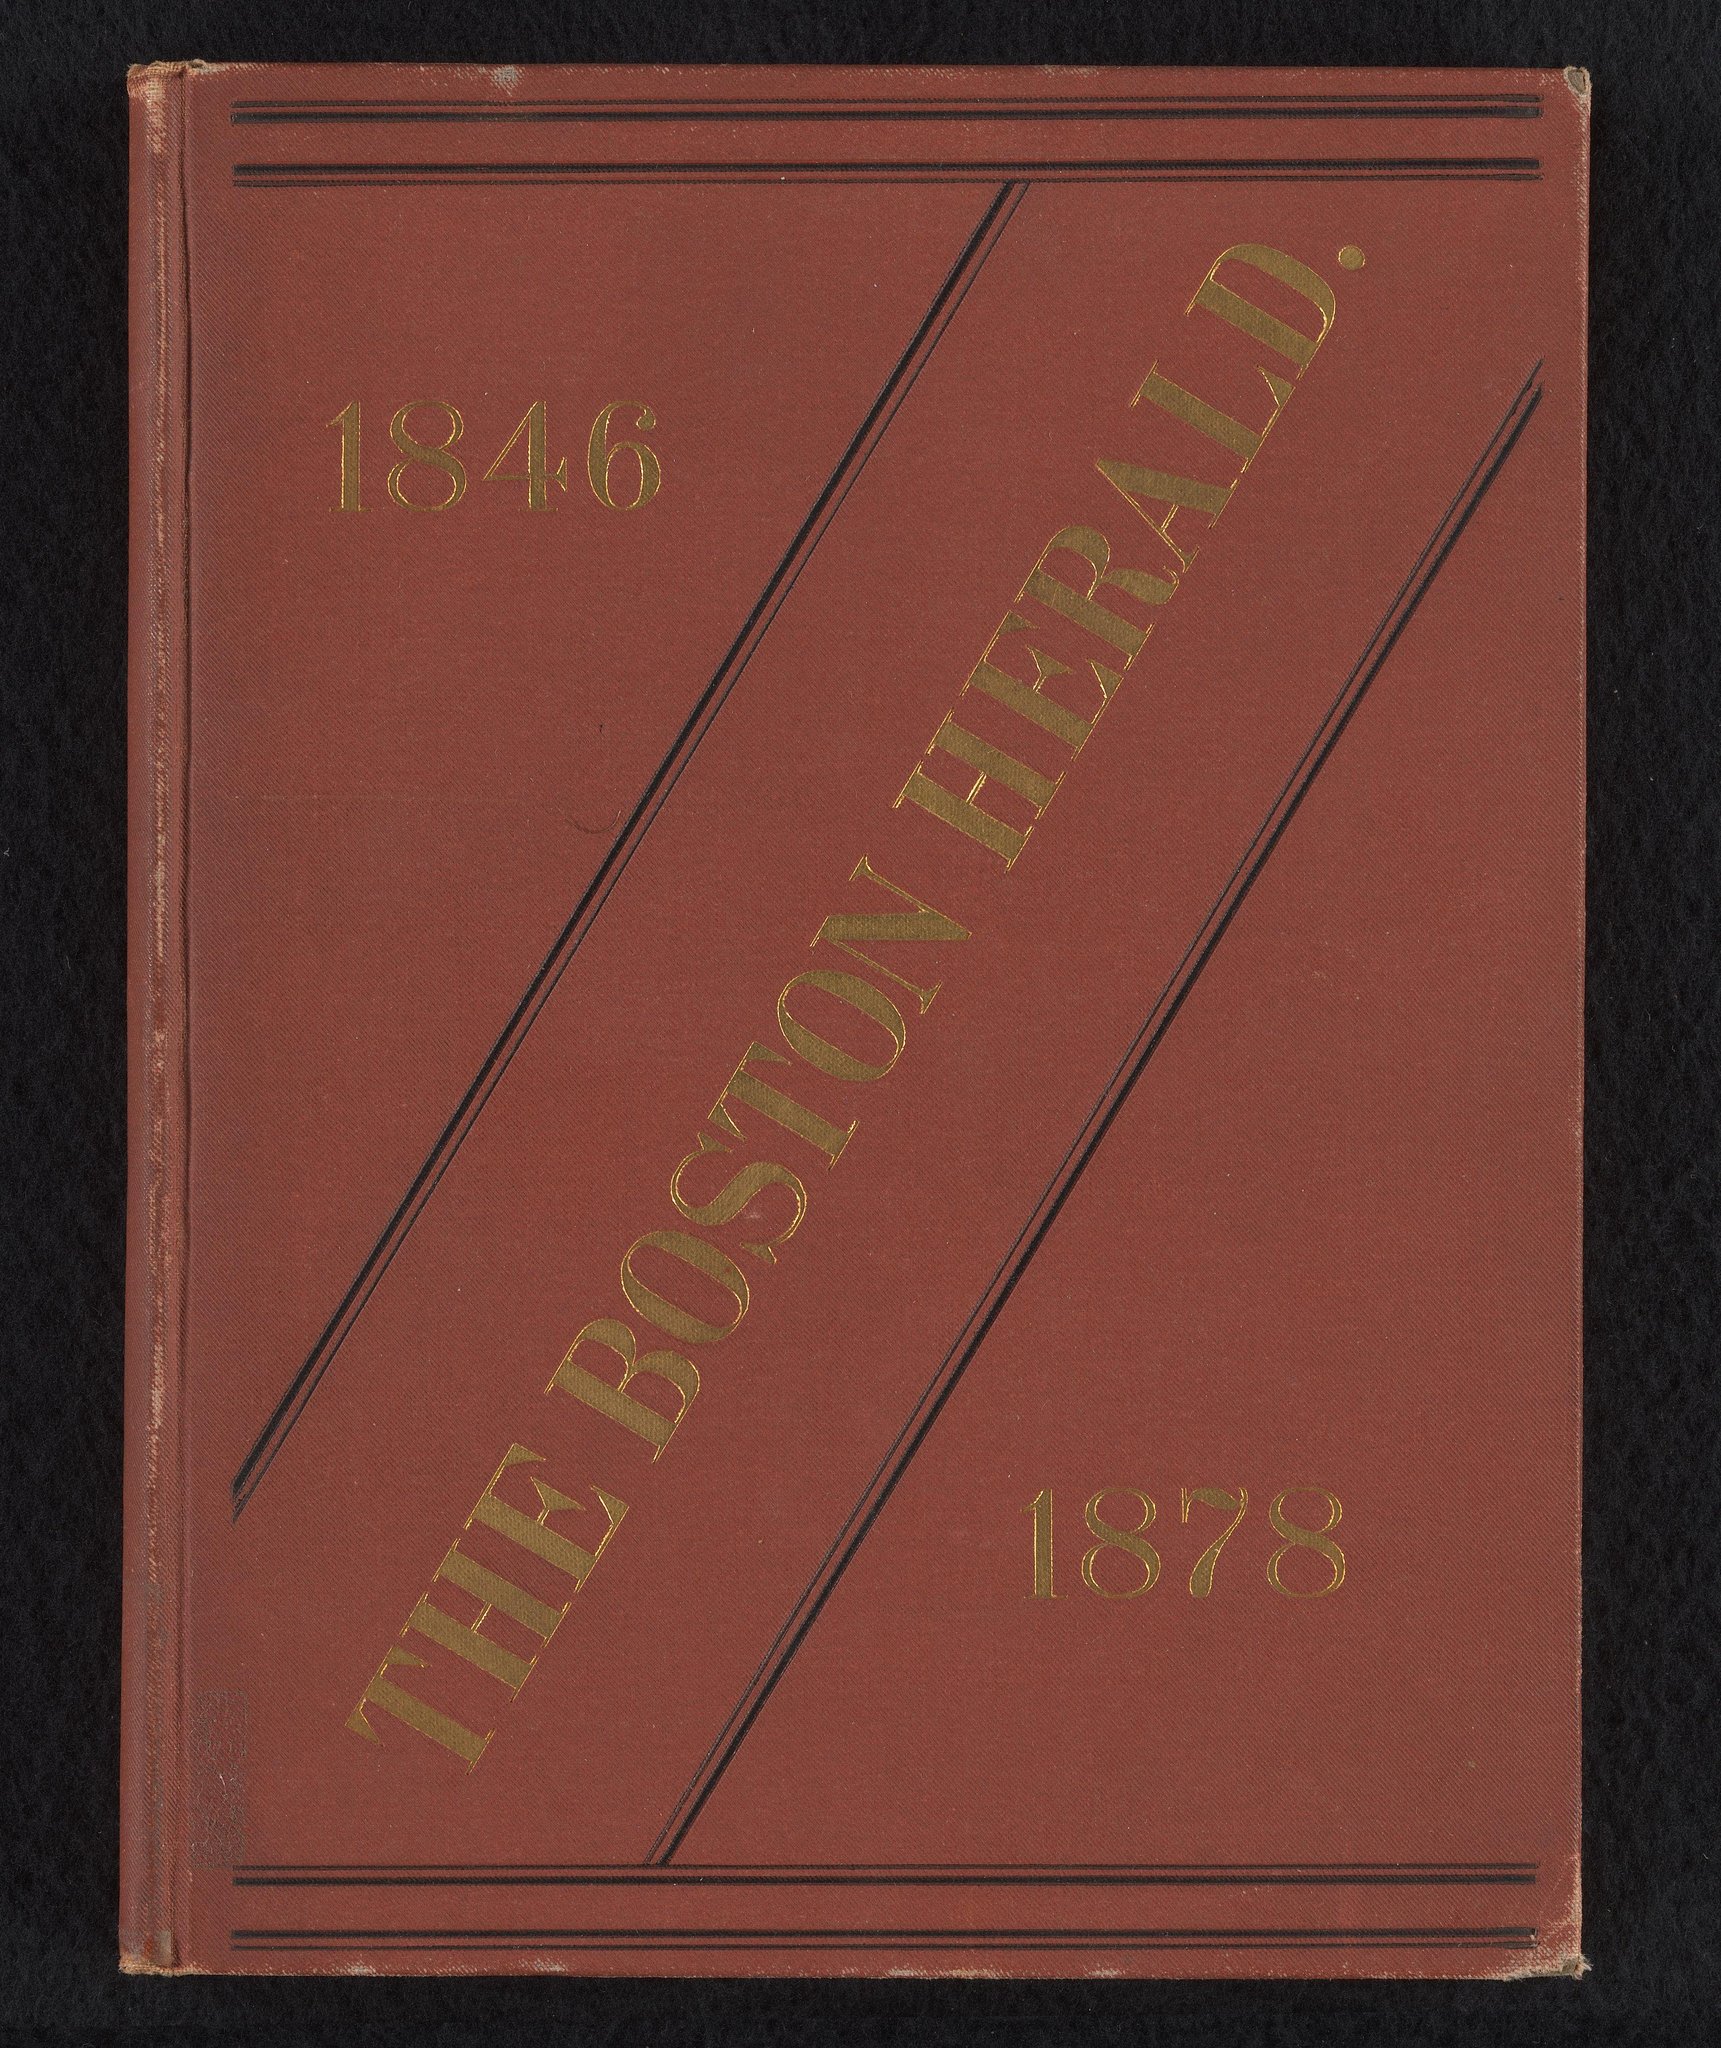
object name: book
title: The Boston Herald and its History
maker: Anonymous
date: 1878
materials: cardboard, paper, textile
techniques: photograph, letterpress printing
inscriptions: name: ‘Peter R. Knights 224 North Brooks St. Madison, Wis. 53715 Cambridge: 14 July 1965’, date: ‘MAR 2006’